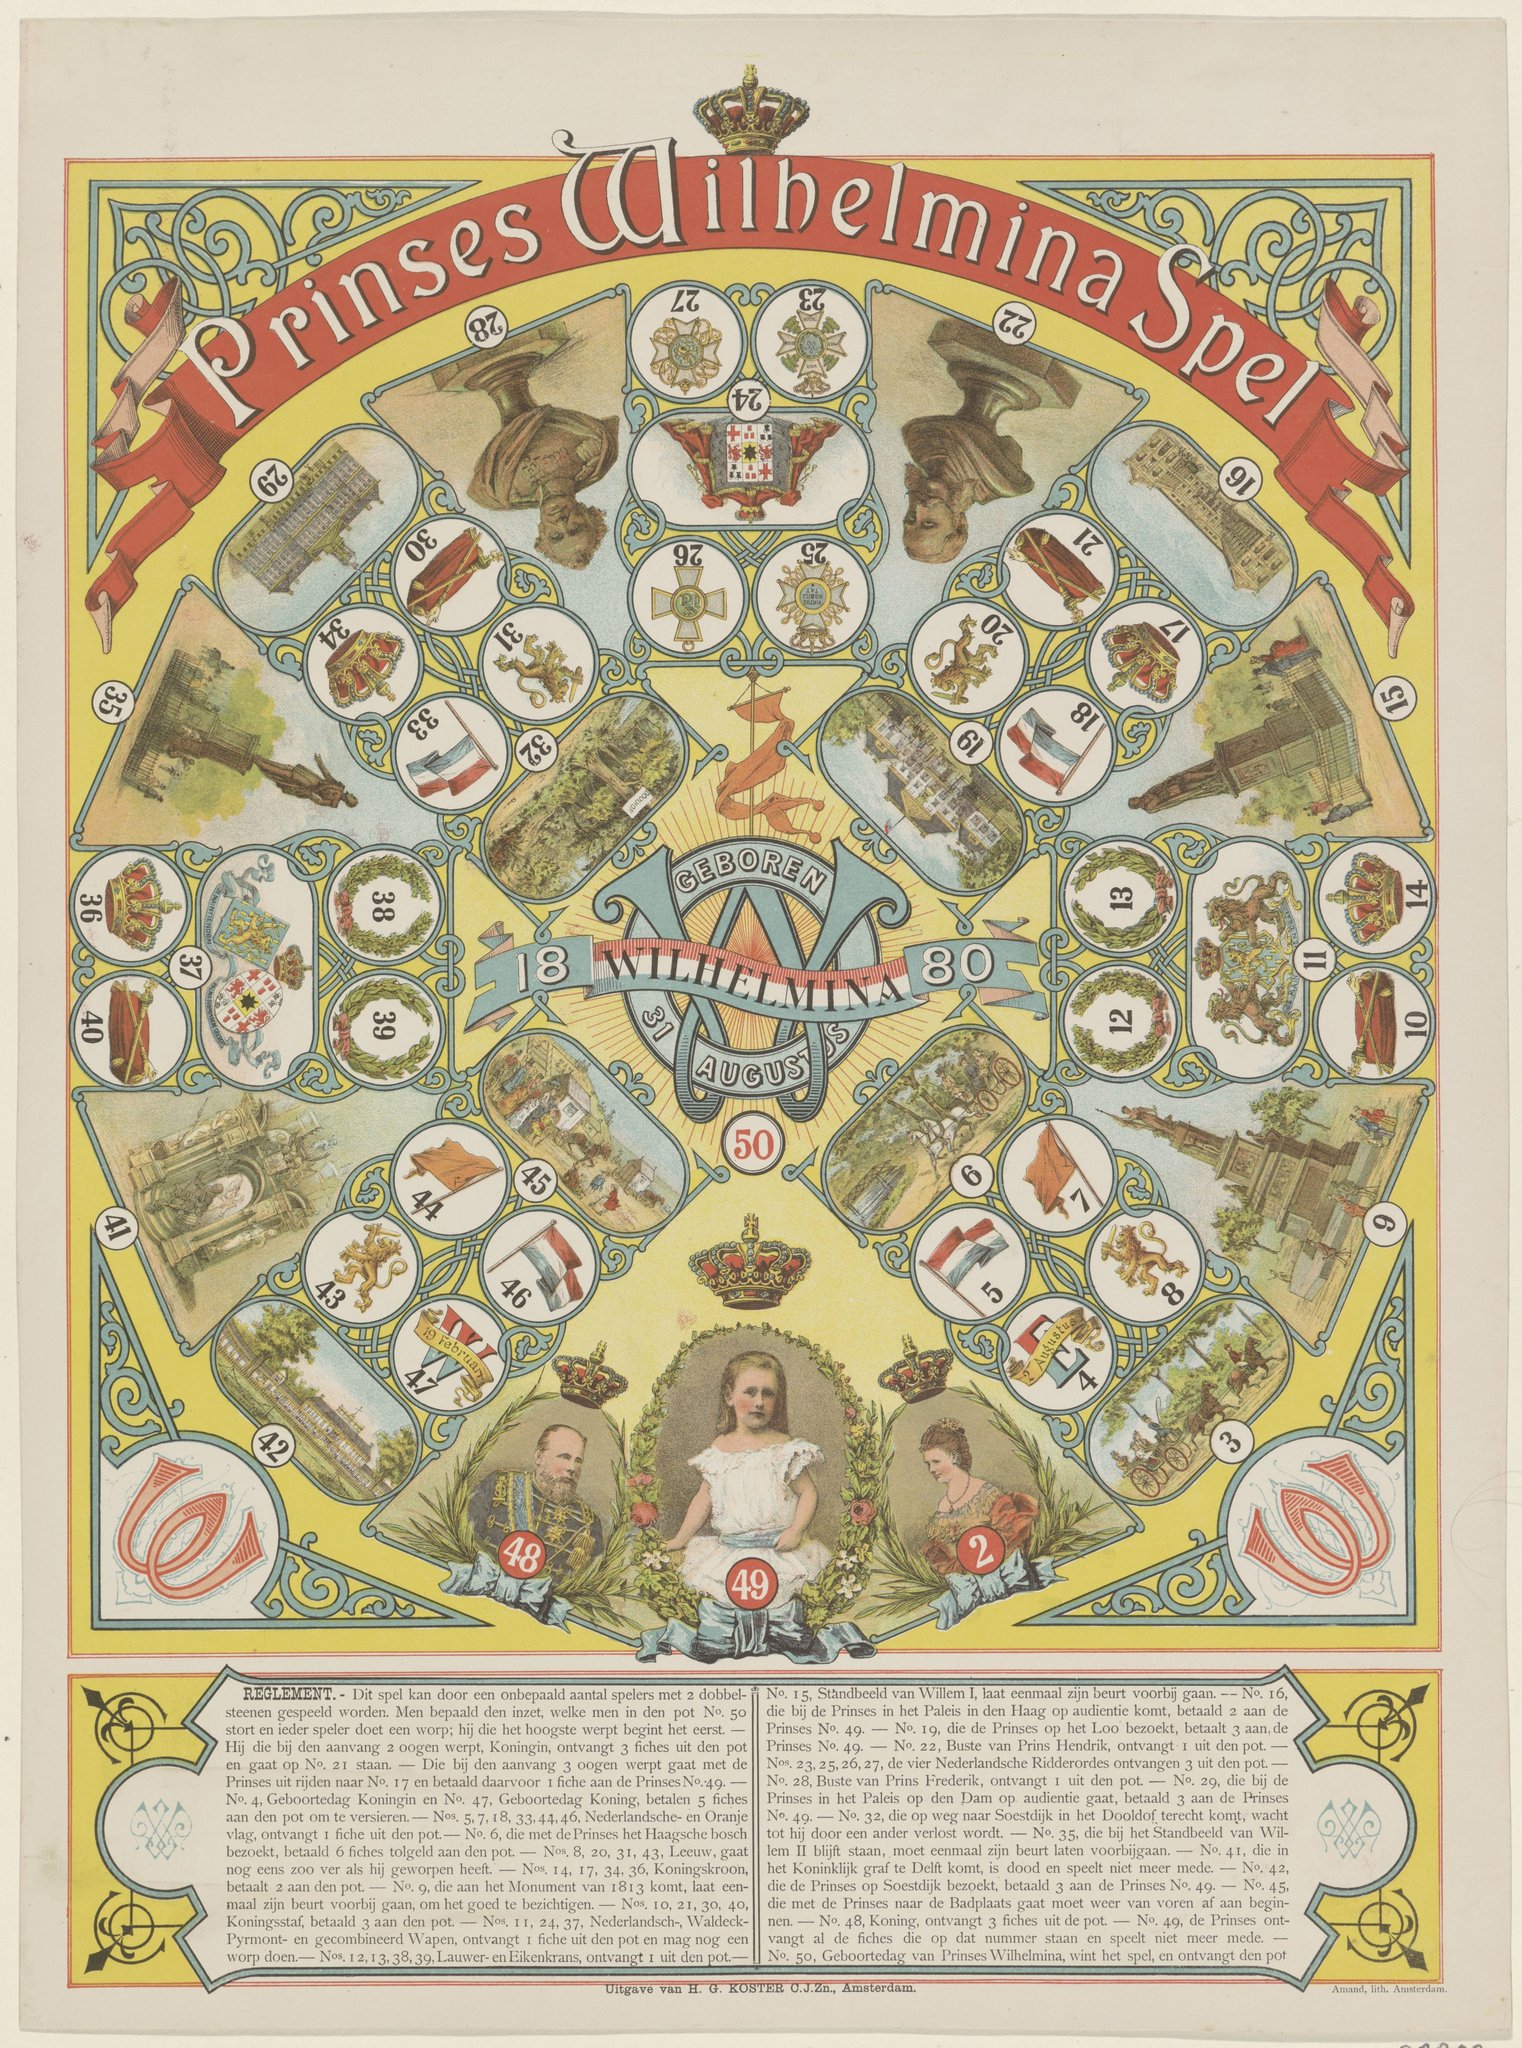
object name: popular print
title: Prinses Wilhelmina spel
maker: Anonymous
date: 1885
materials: paper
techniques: lithograph, letterpress printing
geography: amsterdam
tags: print maker, wilhelmina of the netherlands, berlin, william i of the netherlands, the hague, william ii of the netherlands, board-games of chance, board-games, royal palace of amsterdam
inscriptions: collector's mark: Lugt 2760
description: Bordspel met vakjes genummerd van 1 tot en met 50, met midden onder een portret van de prinses. In de vakjes verschillende attributen, monumenten en evenementen uit het Oranjehuis. Onder de voorstelling de spelregels in twee kolommen. Boven de titel op een banderol.